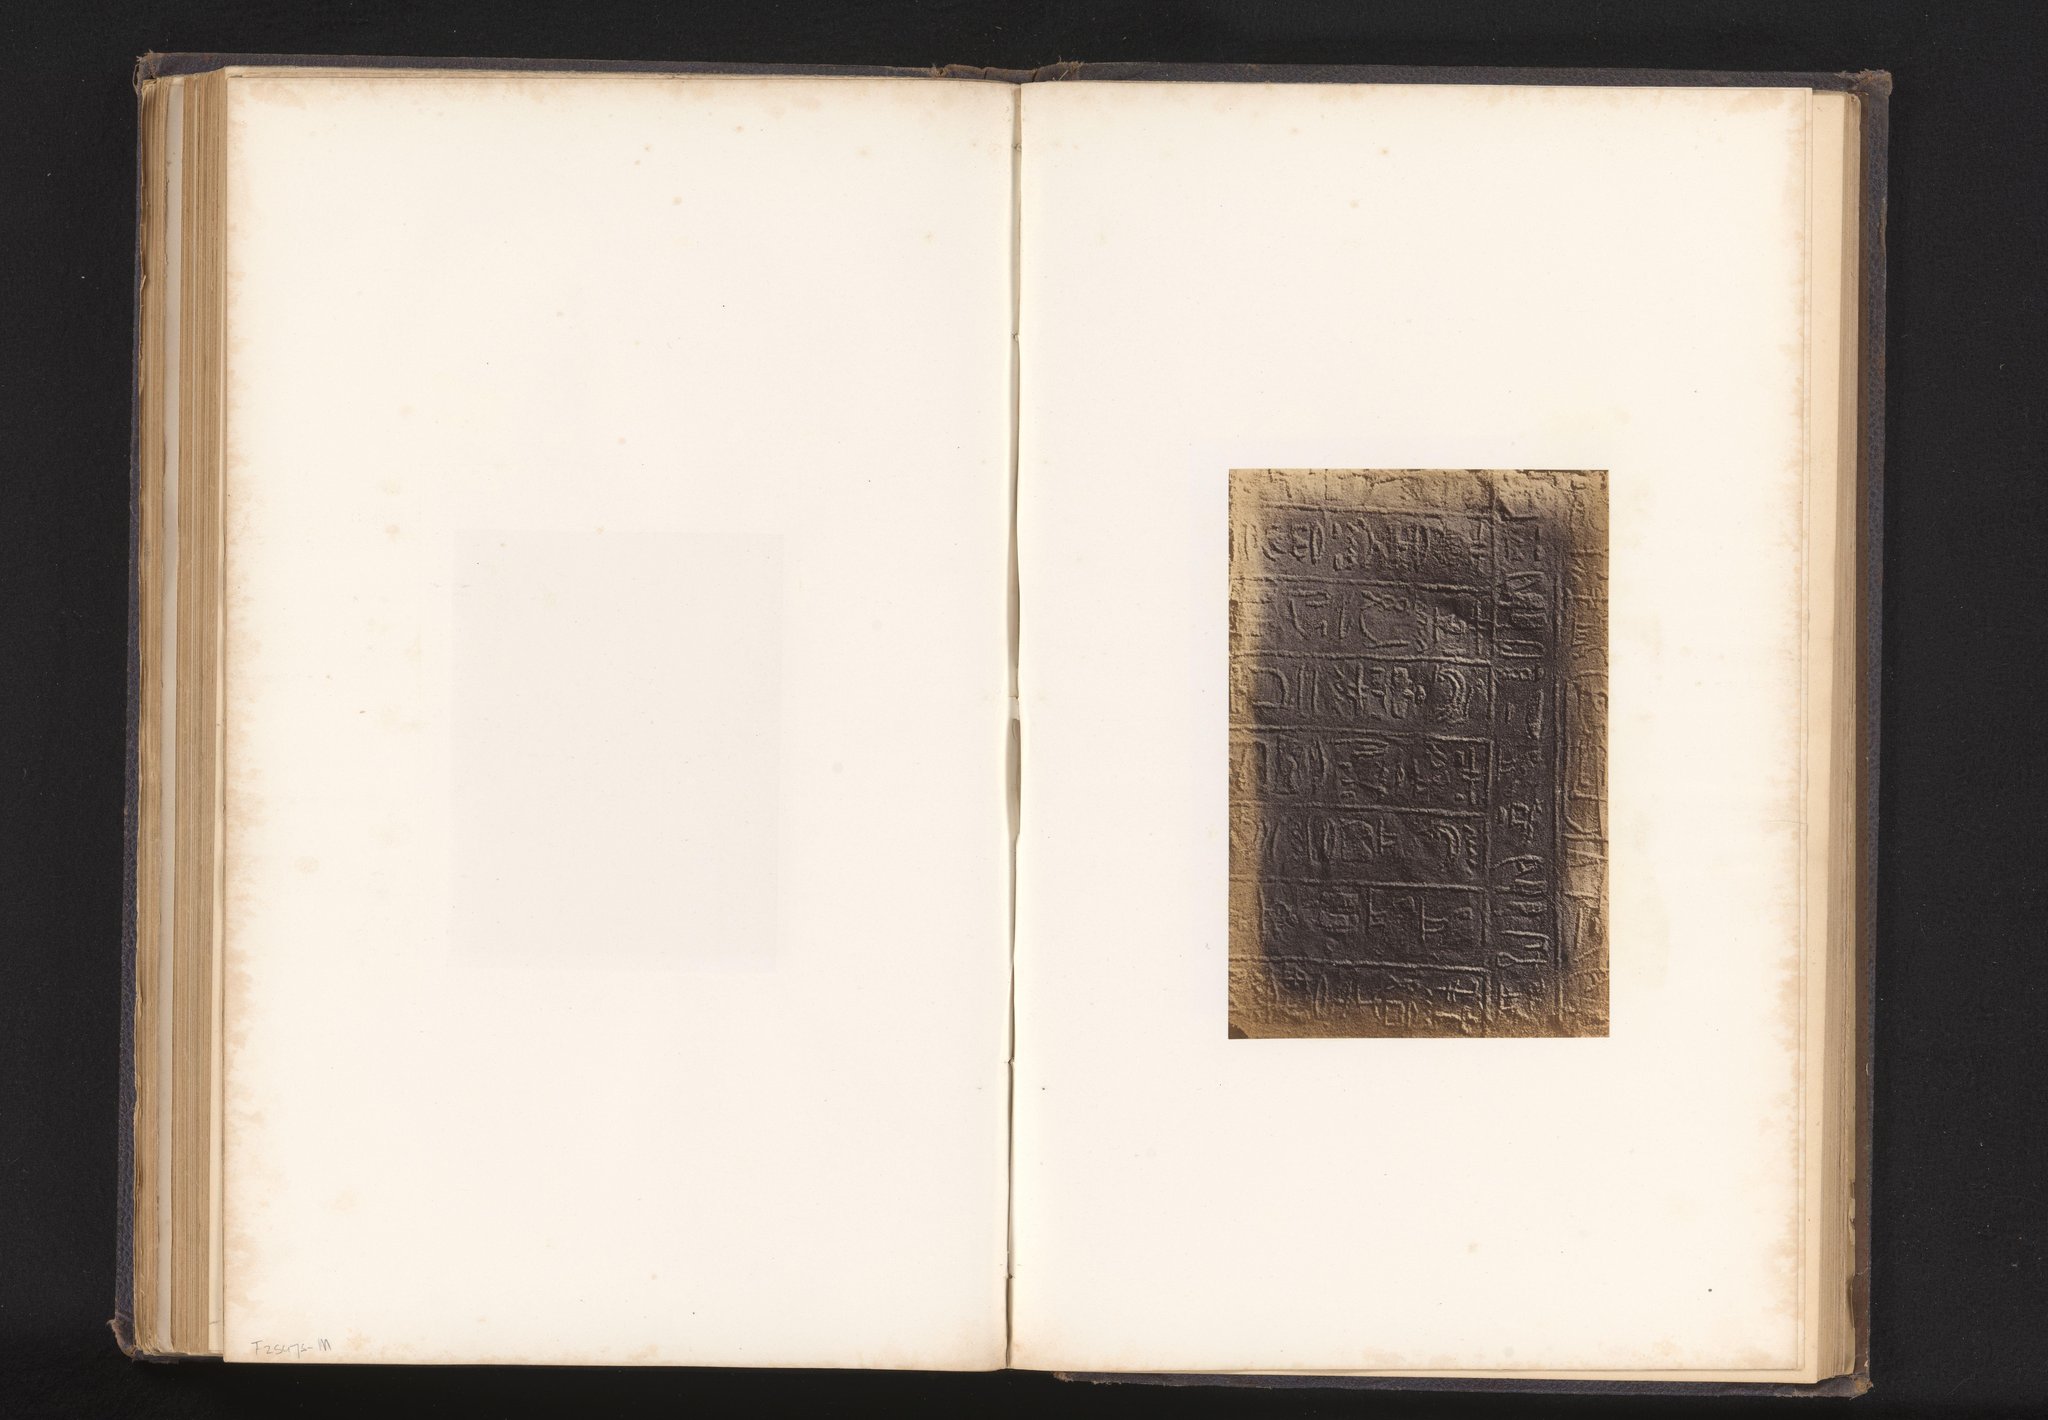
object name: photograph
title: Five Hieroglyphic Tablets from Wadi Maghara (Photographed from casts taken by the Rev. Pierce Butler)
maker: a.j. brown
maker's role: fotograaf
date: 1857-1862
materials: paper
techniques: albumen print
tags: egyptian hieroglyphs